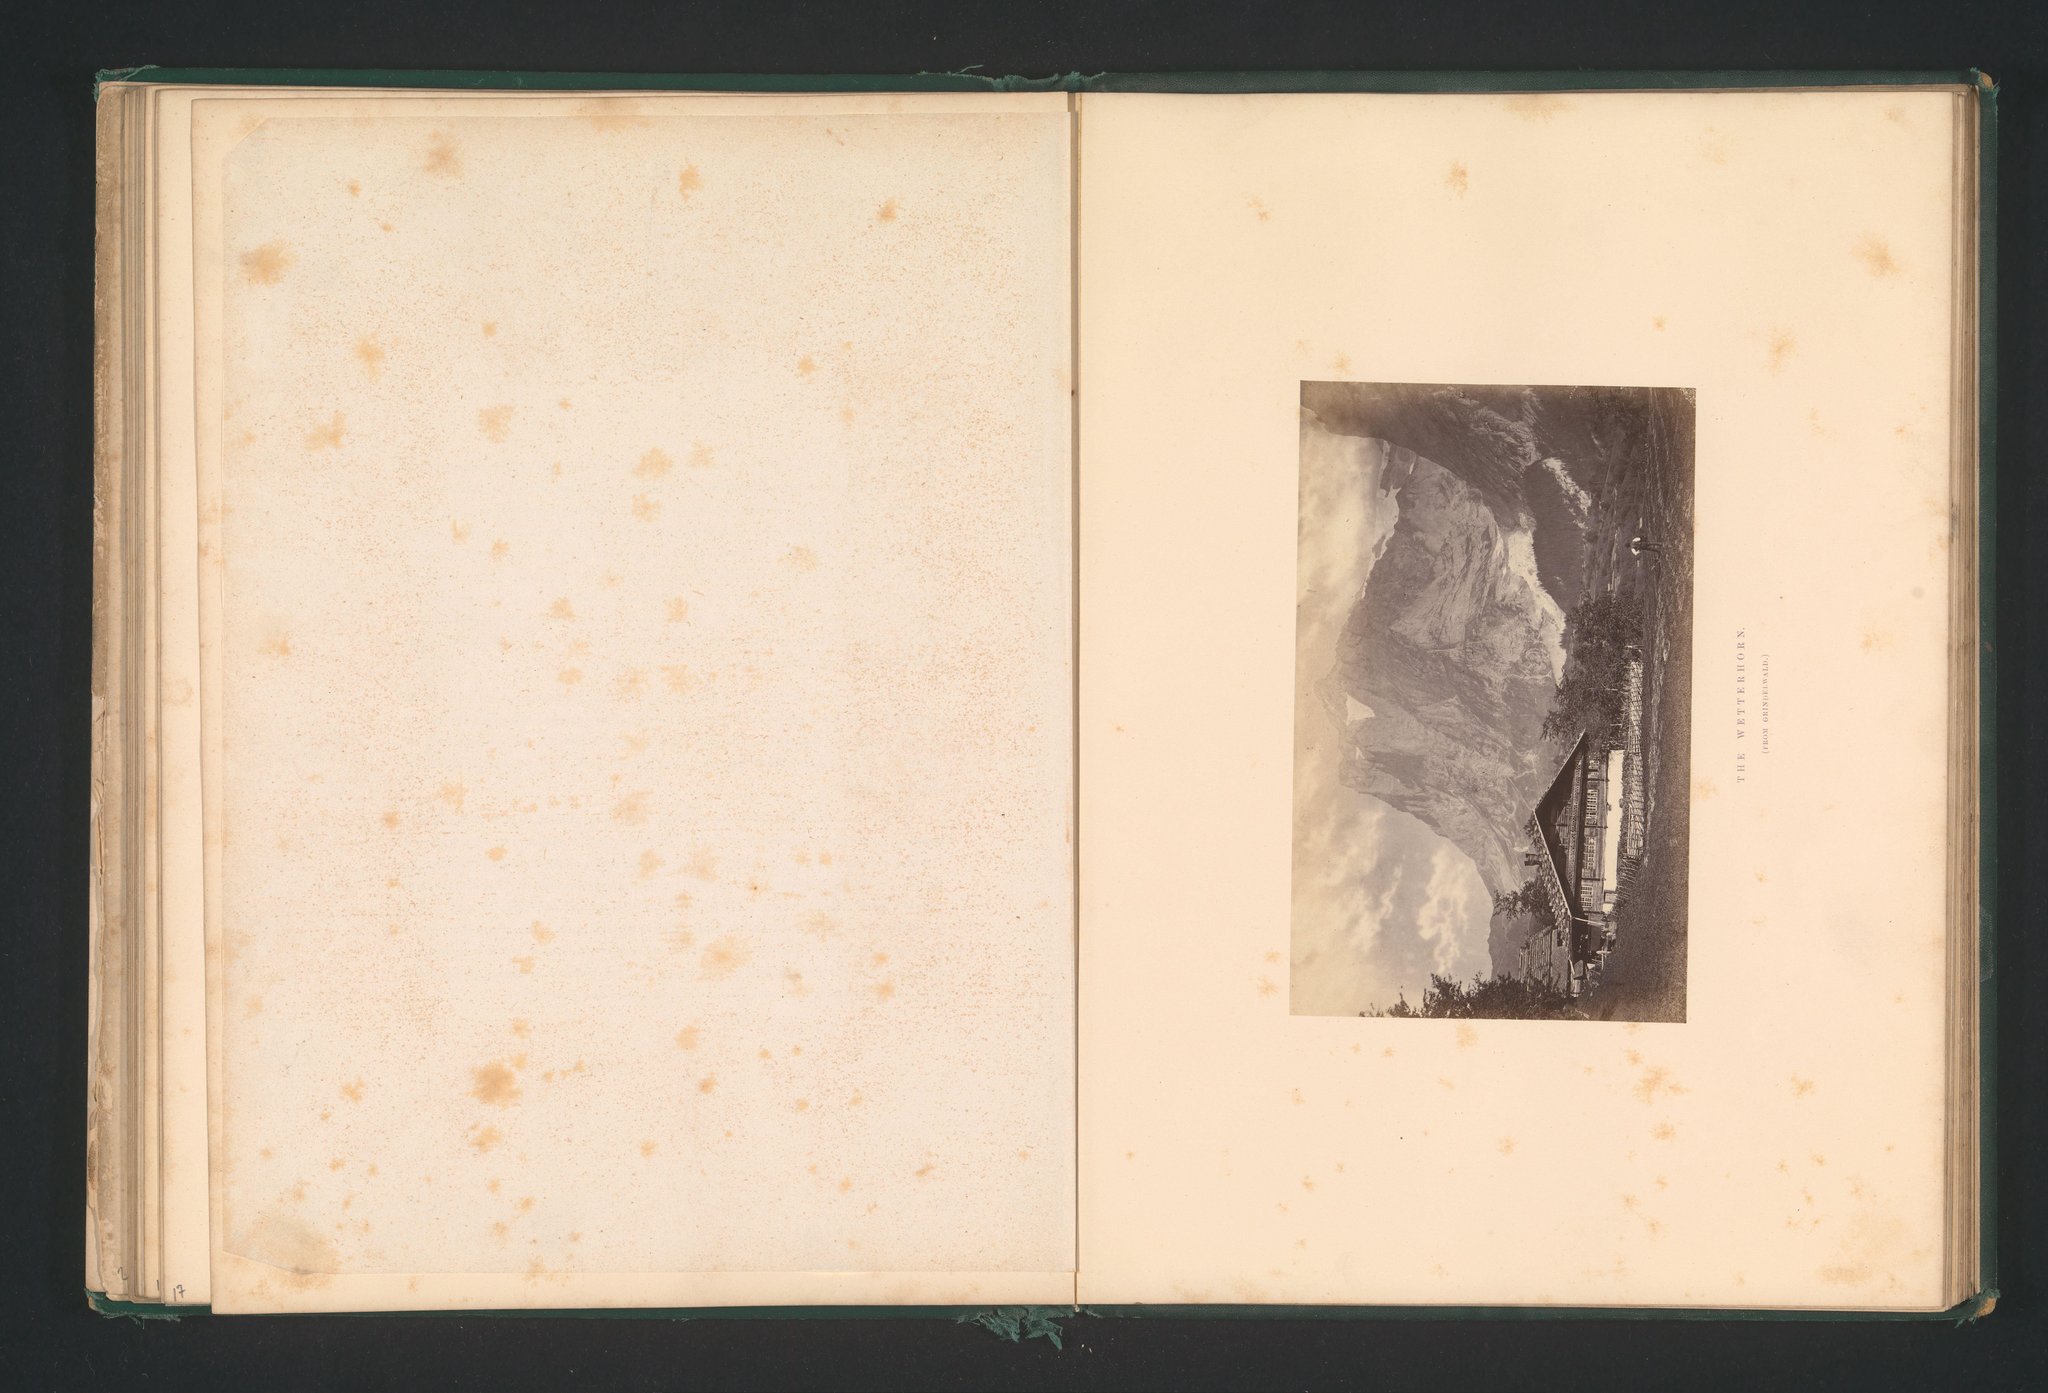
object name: photograph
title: Gezicht op de Wetterhorn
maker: stephen thompson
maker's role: fotograaf, schrijver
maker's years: 1831-1893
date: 1863-1868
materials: photographic support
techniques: albumen print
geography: grindelwald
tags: landscapes (+ landscape with figures, staffage), mountains